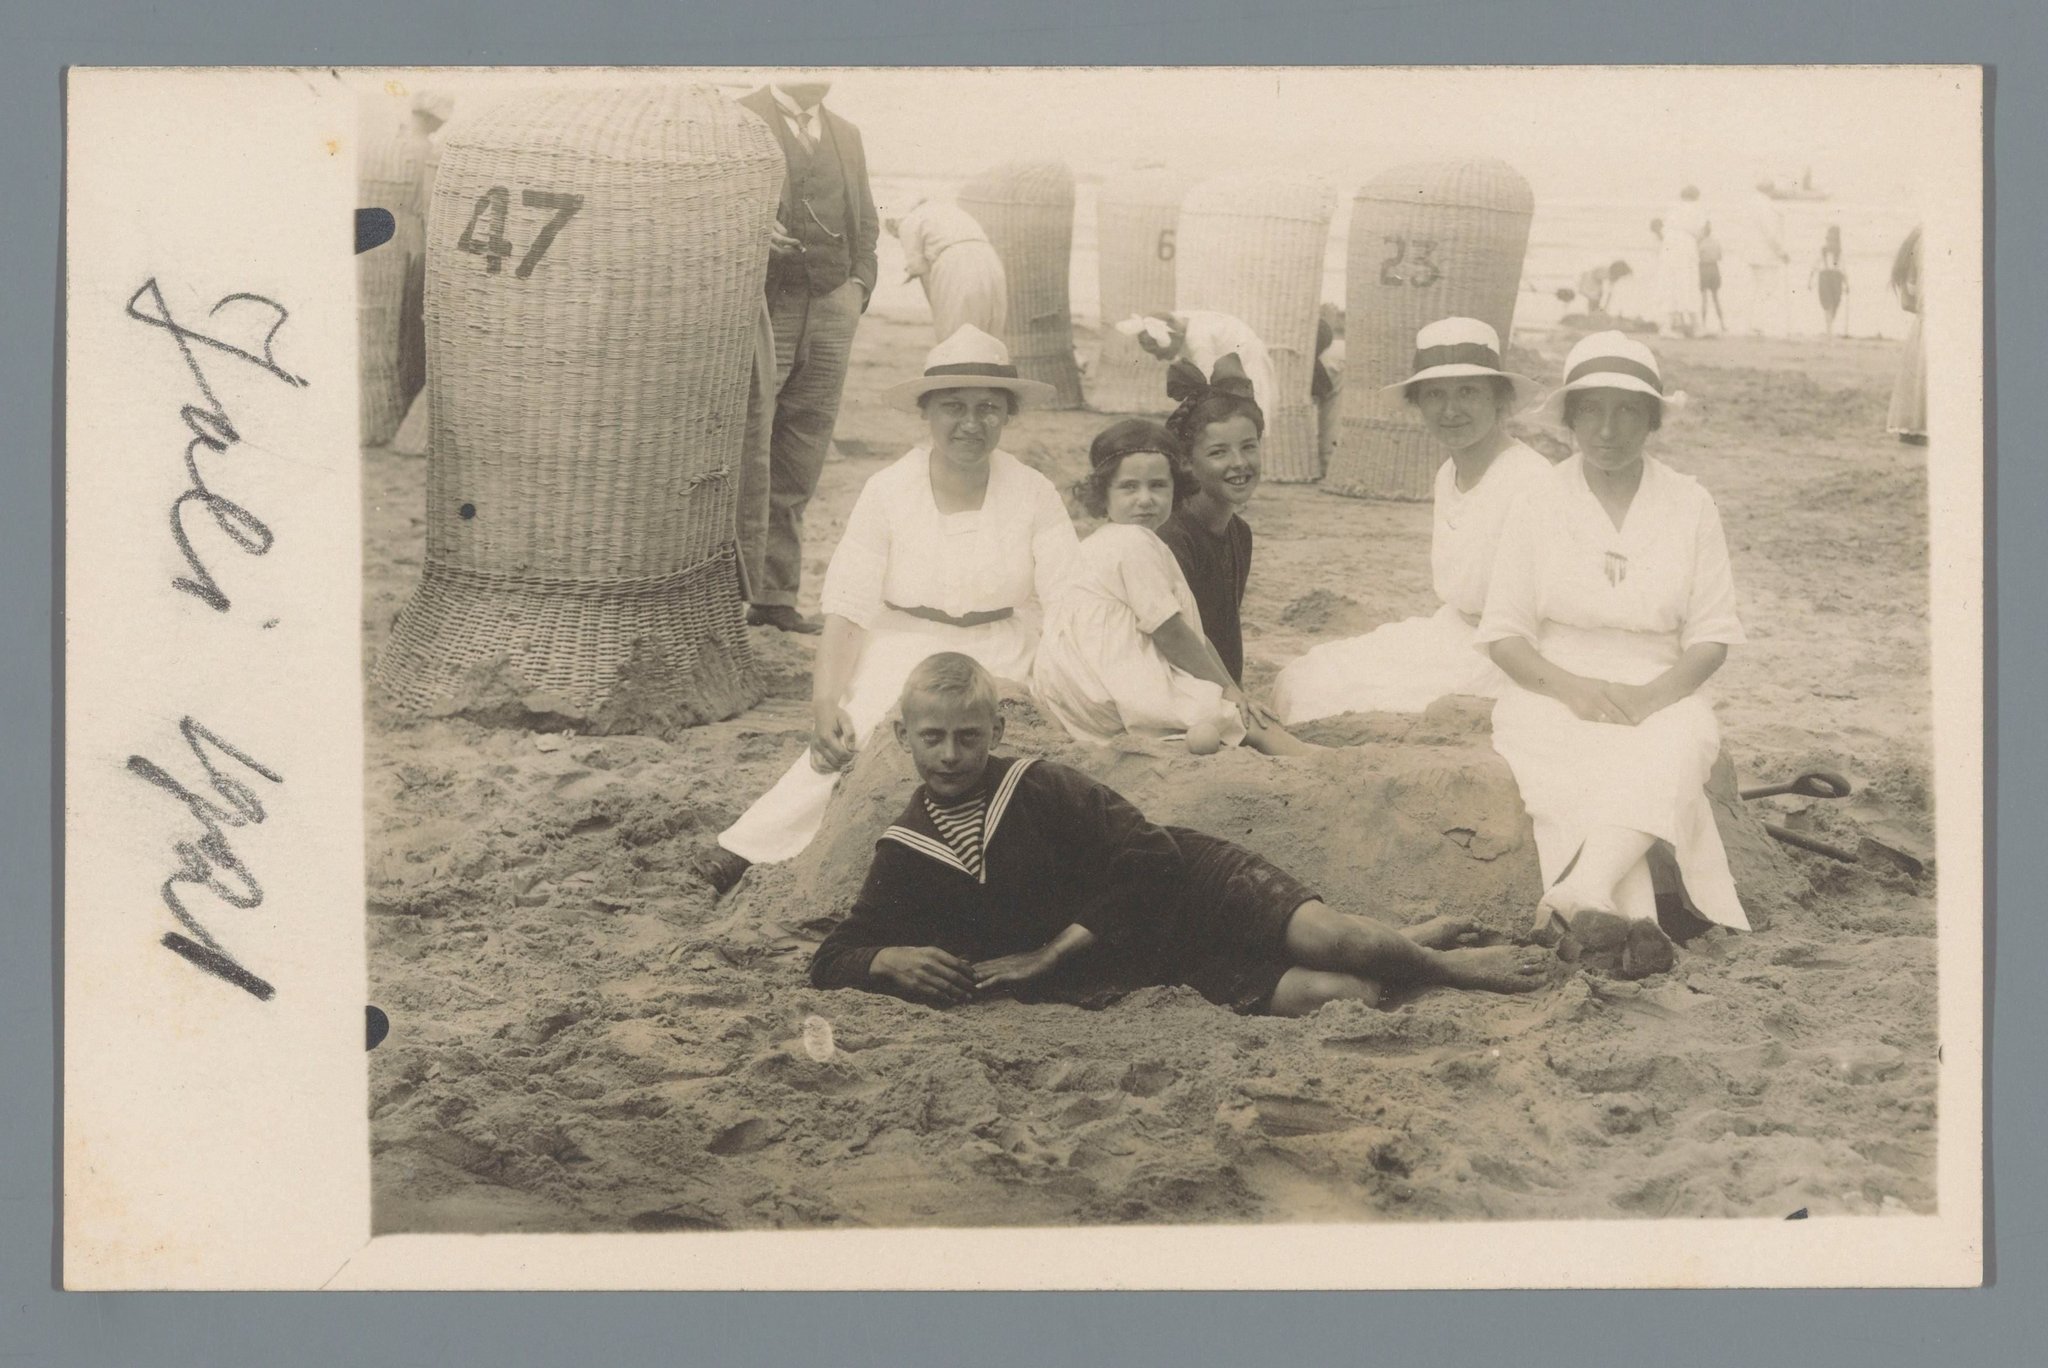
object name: ansichtkaart, prentbriefkaart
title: Portret van drie vrouwen met kinderen op een strand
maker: Anonymous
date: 1907-1921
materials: photographic support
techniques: gelatin silver print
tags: beach (as place of recreation), mother and child(ren), woman and child(ren) (family group)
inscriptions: inscription: ‘Juli 1921’